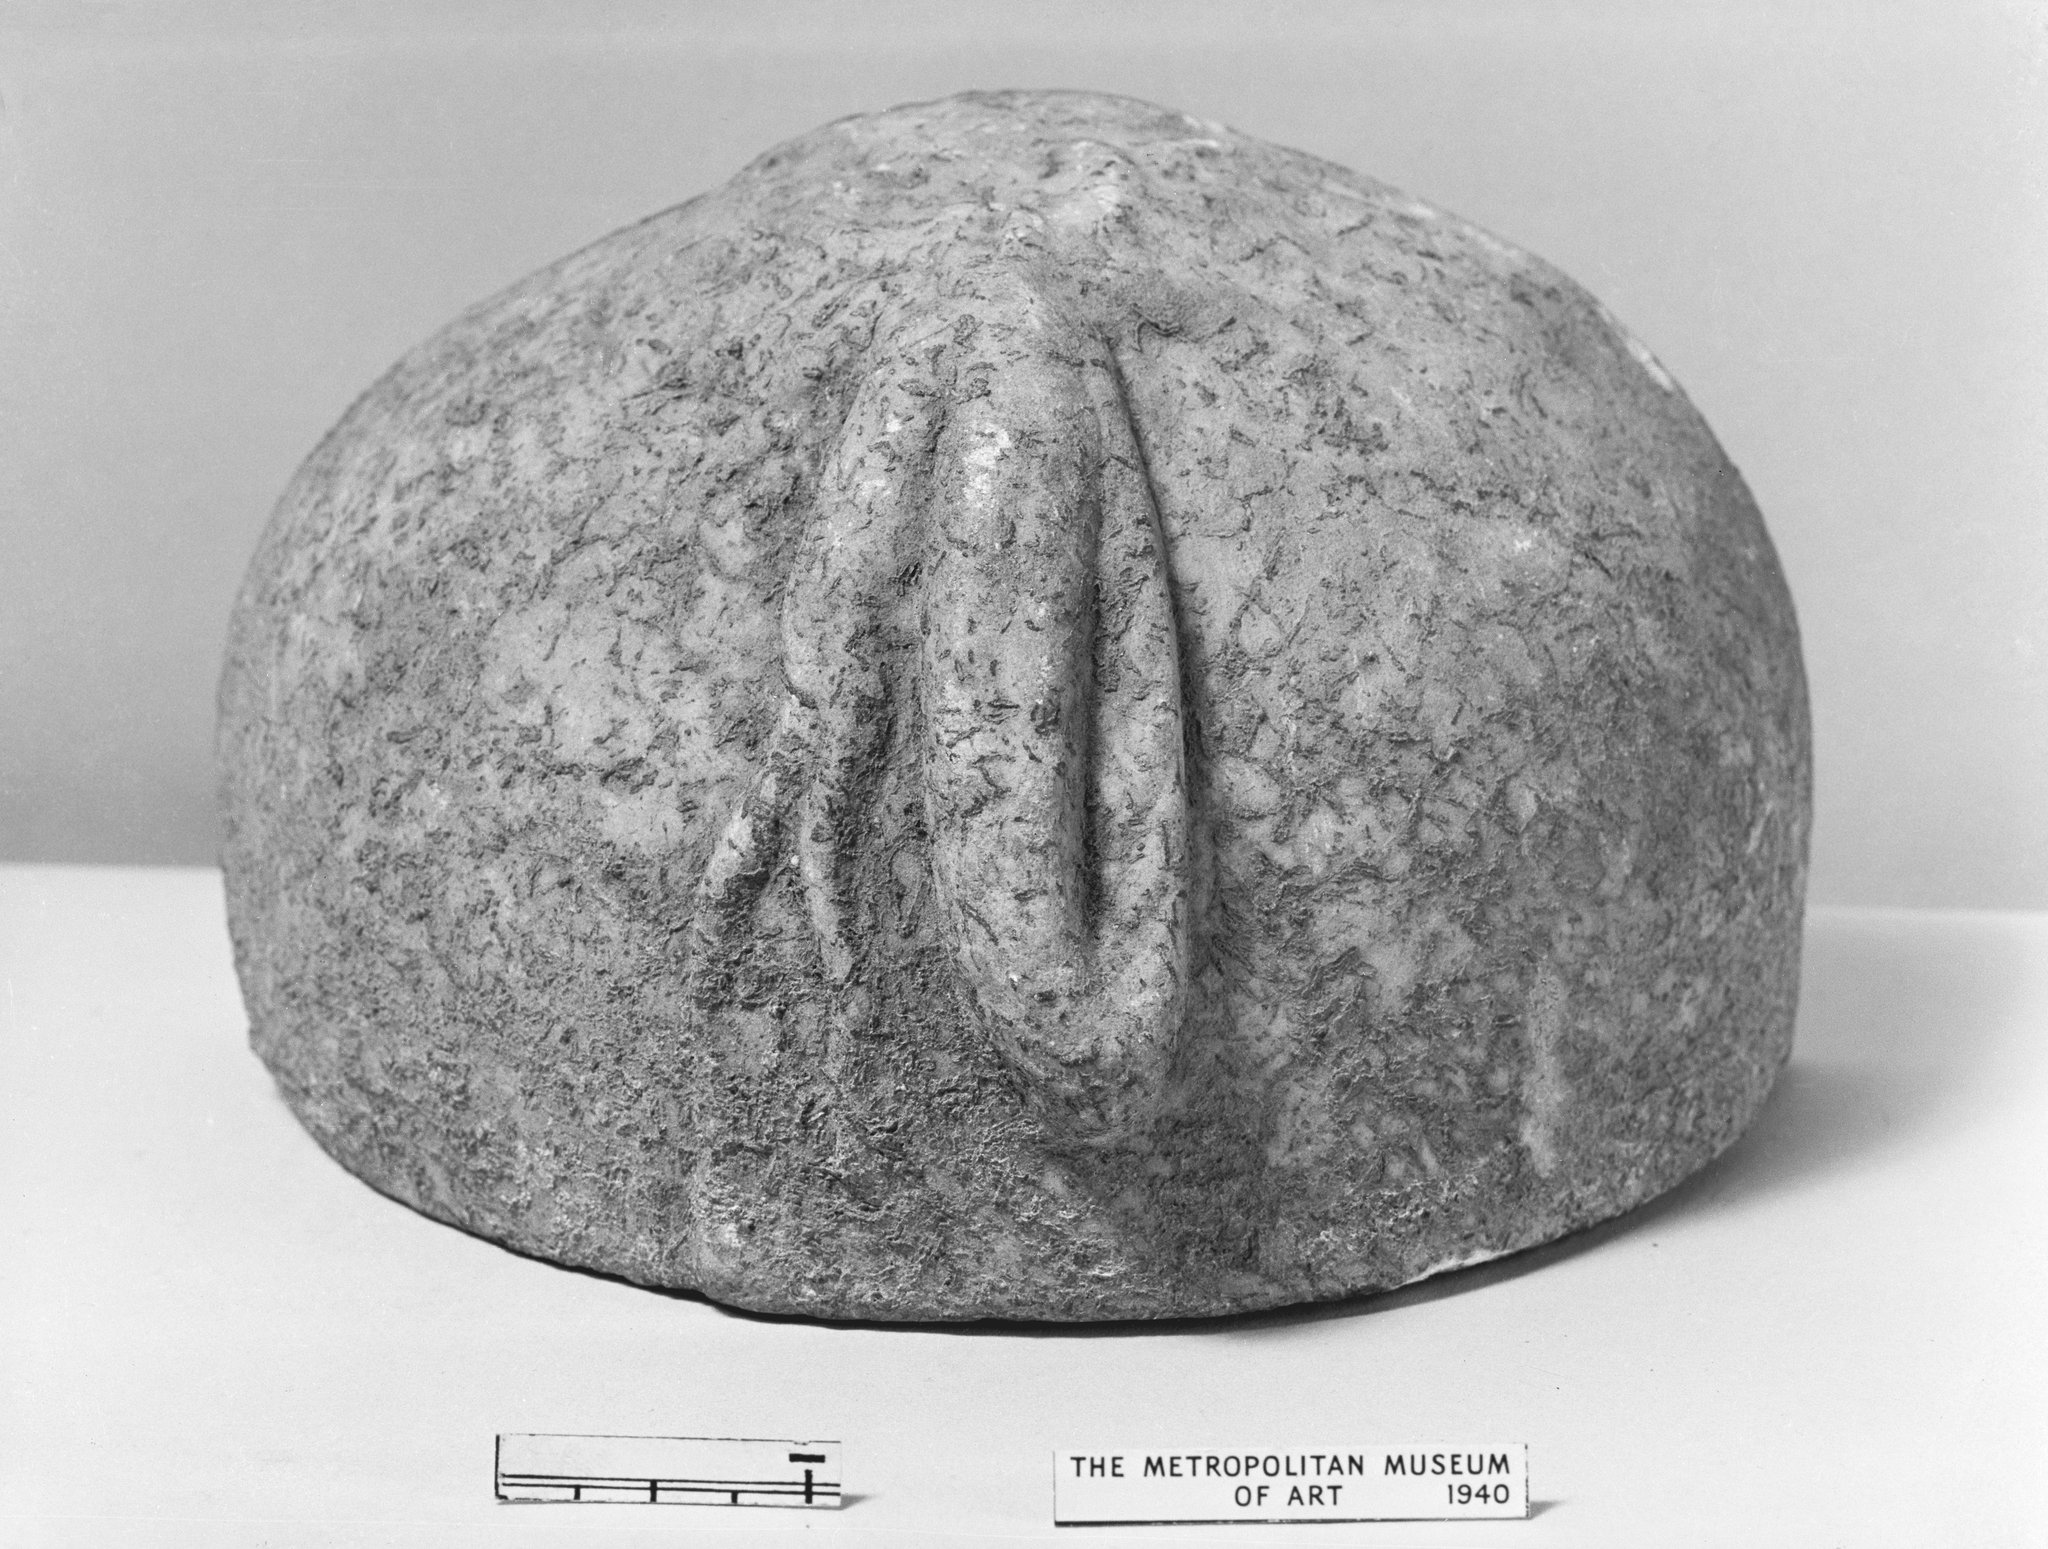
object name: head of a baby, fragmentary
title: Fragment of a child's head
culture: roman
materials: marble